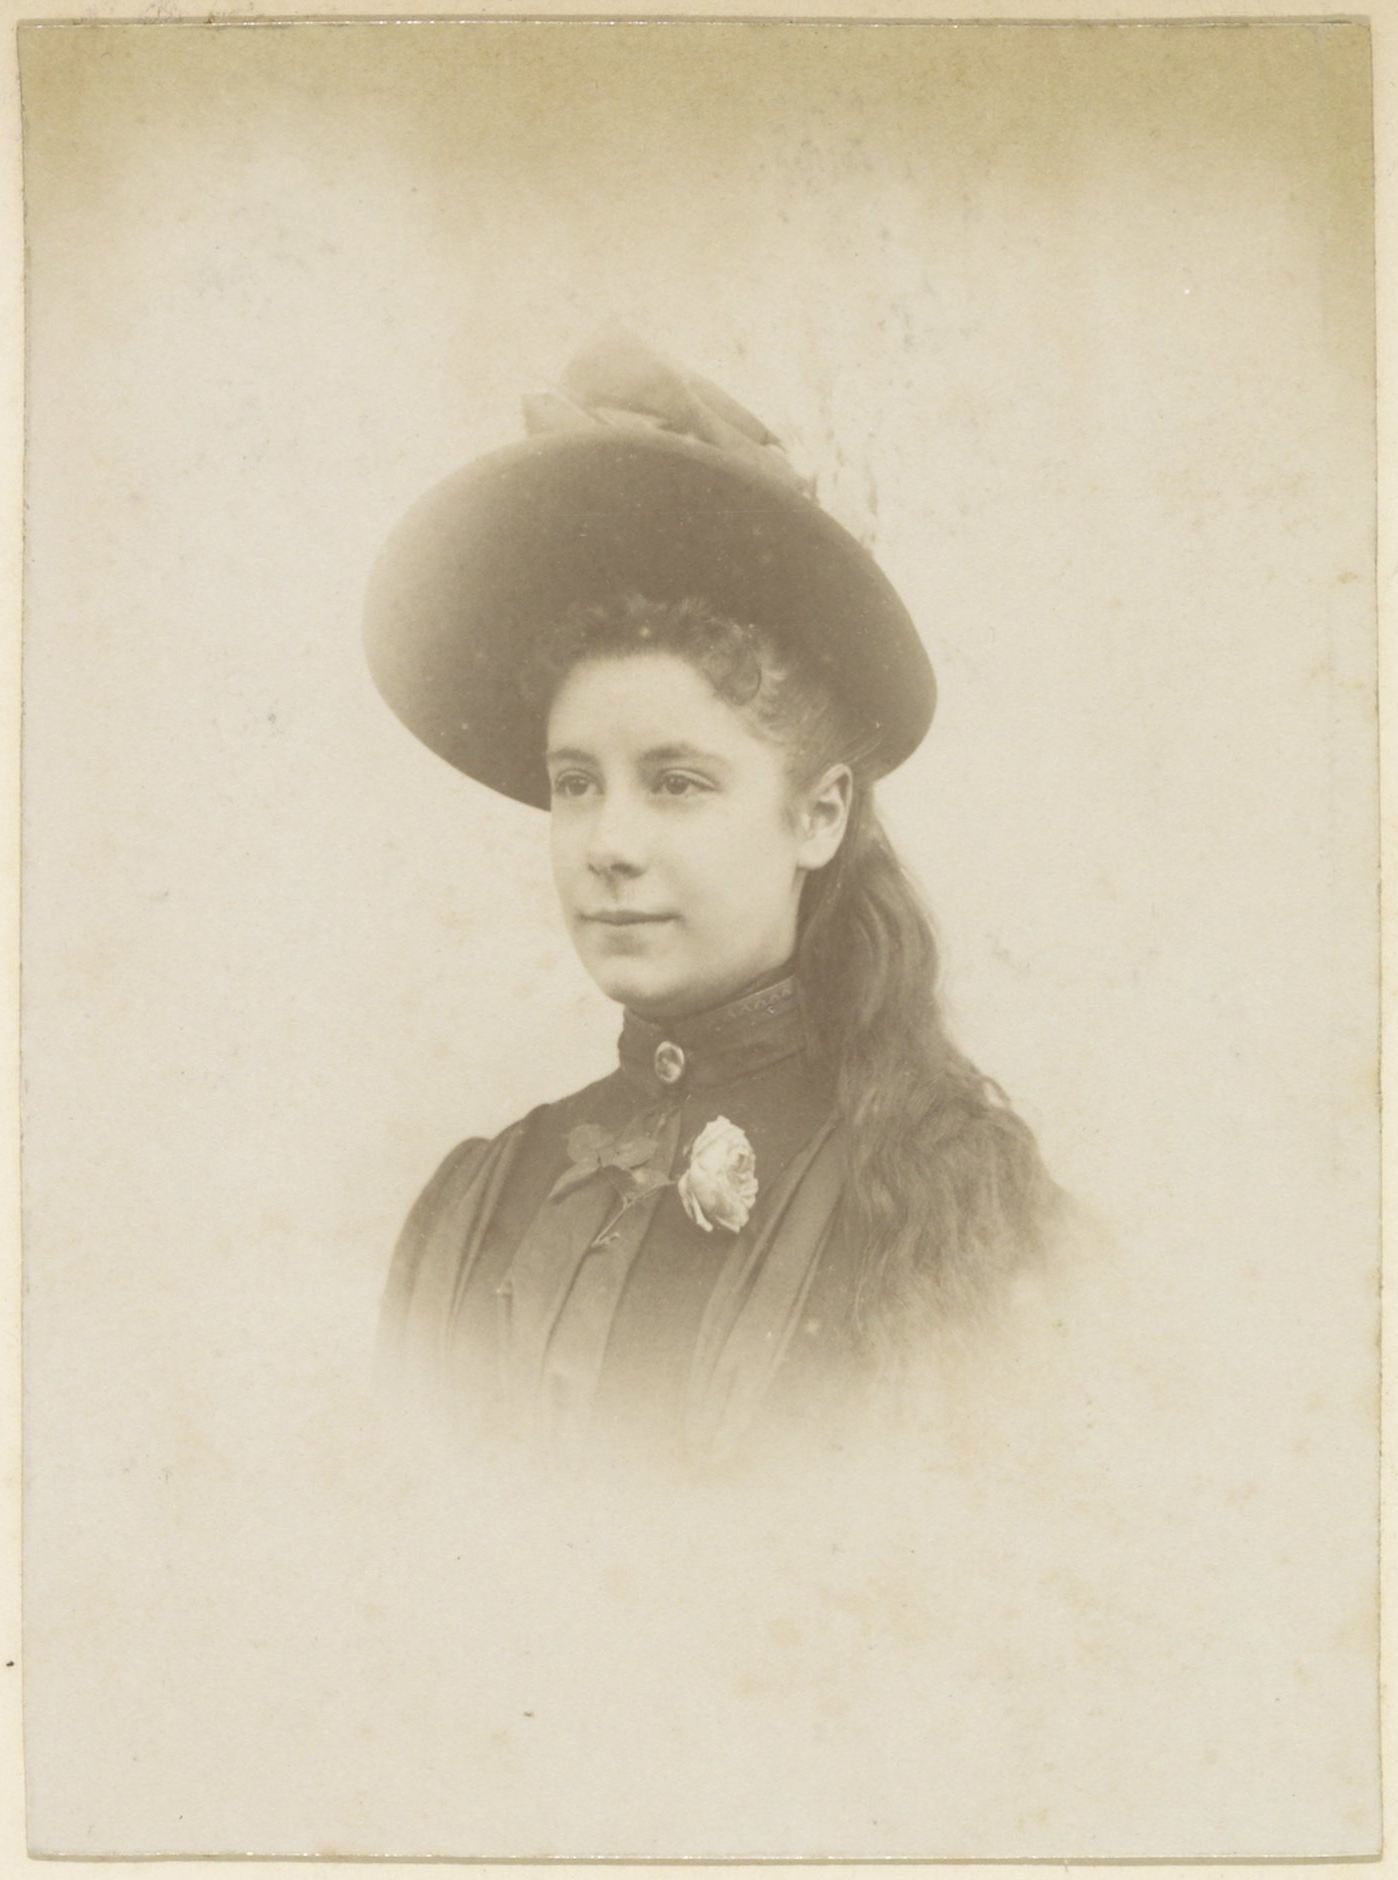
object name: photograph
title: Portret van een Frans meisje met hoed, broche en bloem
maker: Anonymous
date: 1900-1910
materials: paper, photographic support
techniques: albumen print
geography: france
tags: adolescent, young woman, maiden, brooch, agraffe, clasp, head-gear: hat, flowers: rose, france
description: Onderdeel van Fotoalbum van een Franse amateurfotograaf met opnames van een familie, distilleerderij Delizy & Doistau Fils, het leger en bezienswaardigheden in Frankrijk.